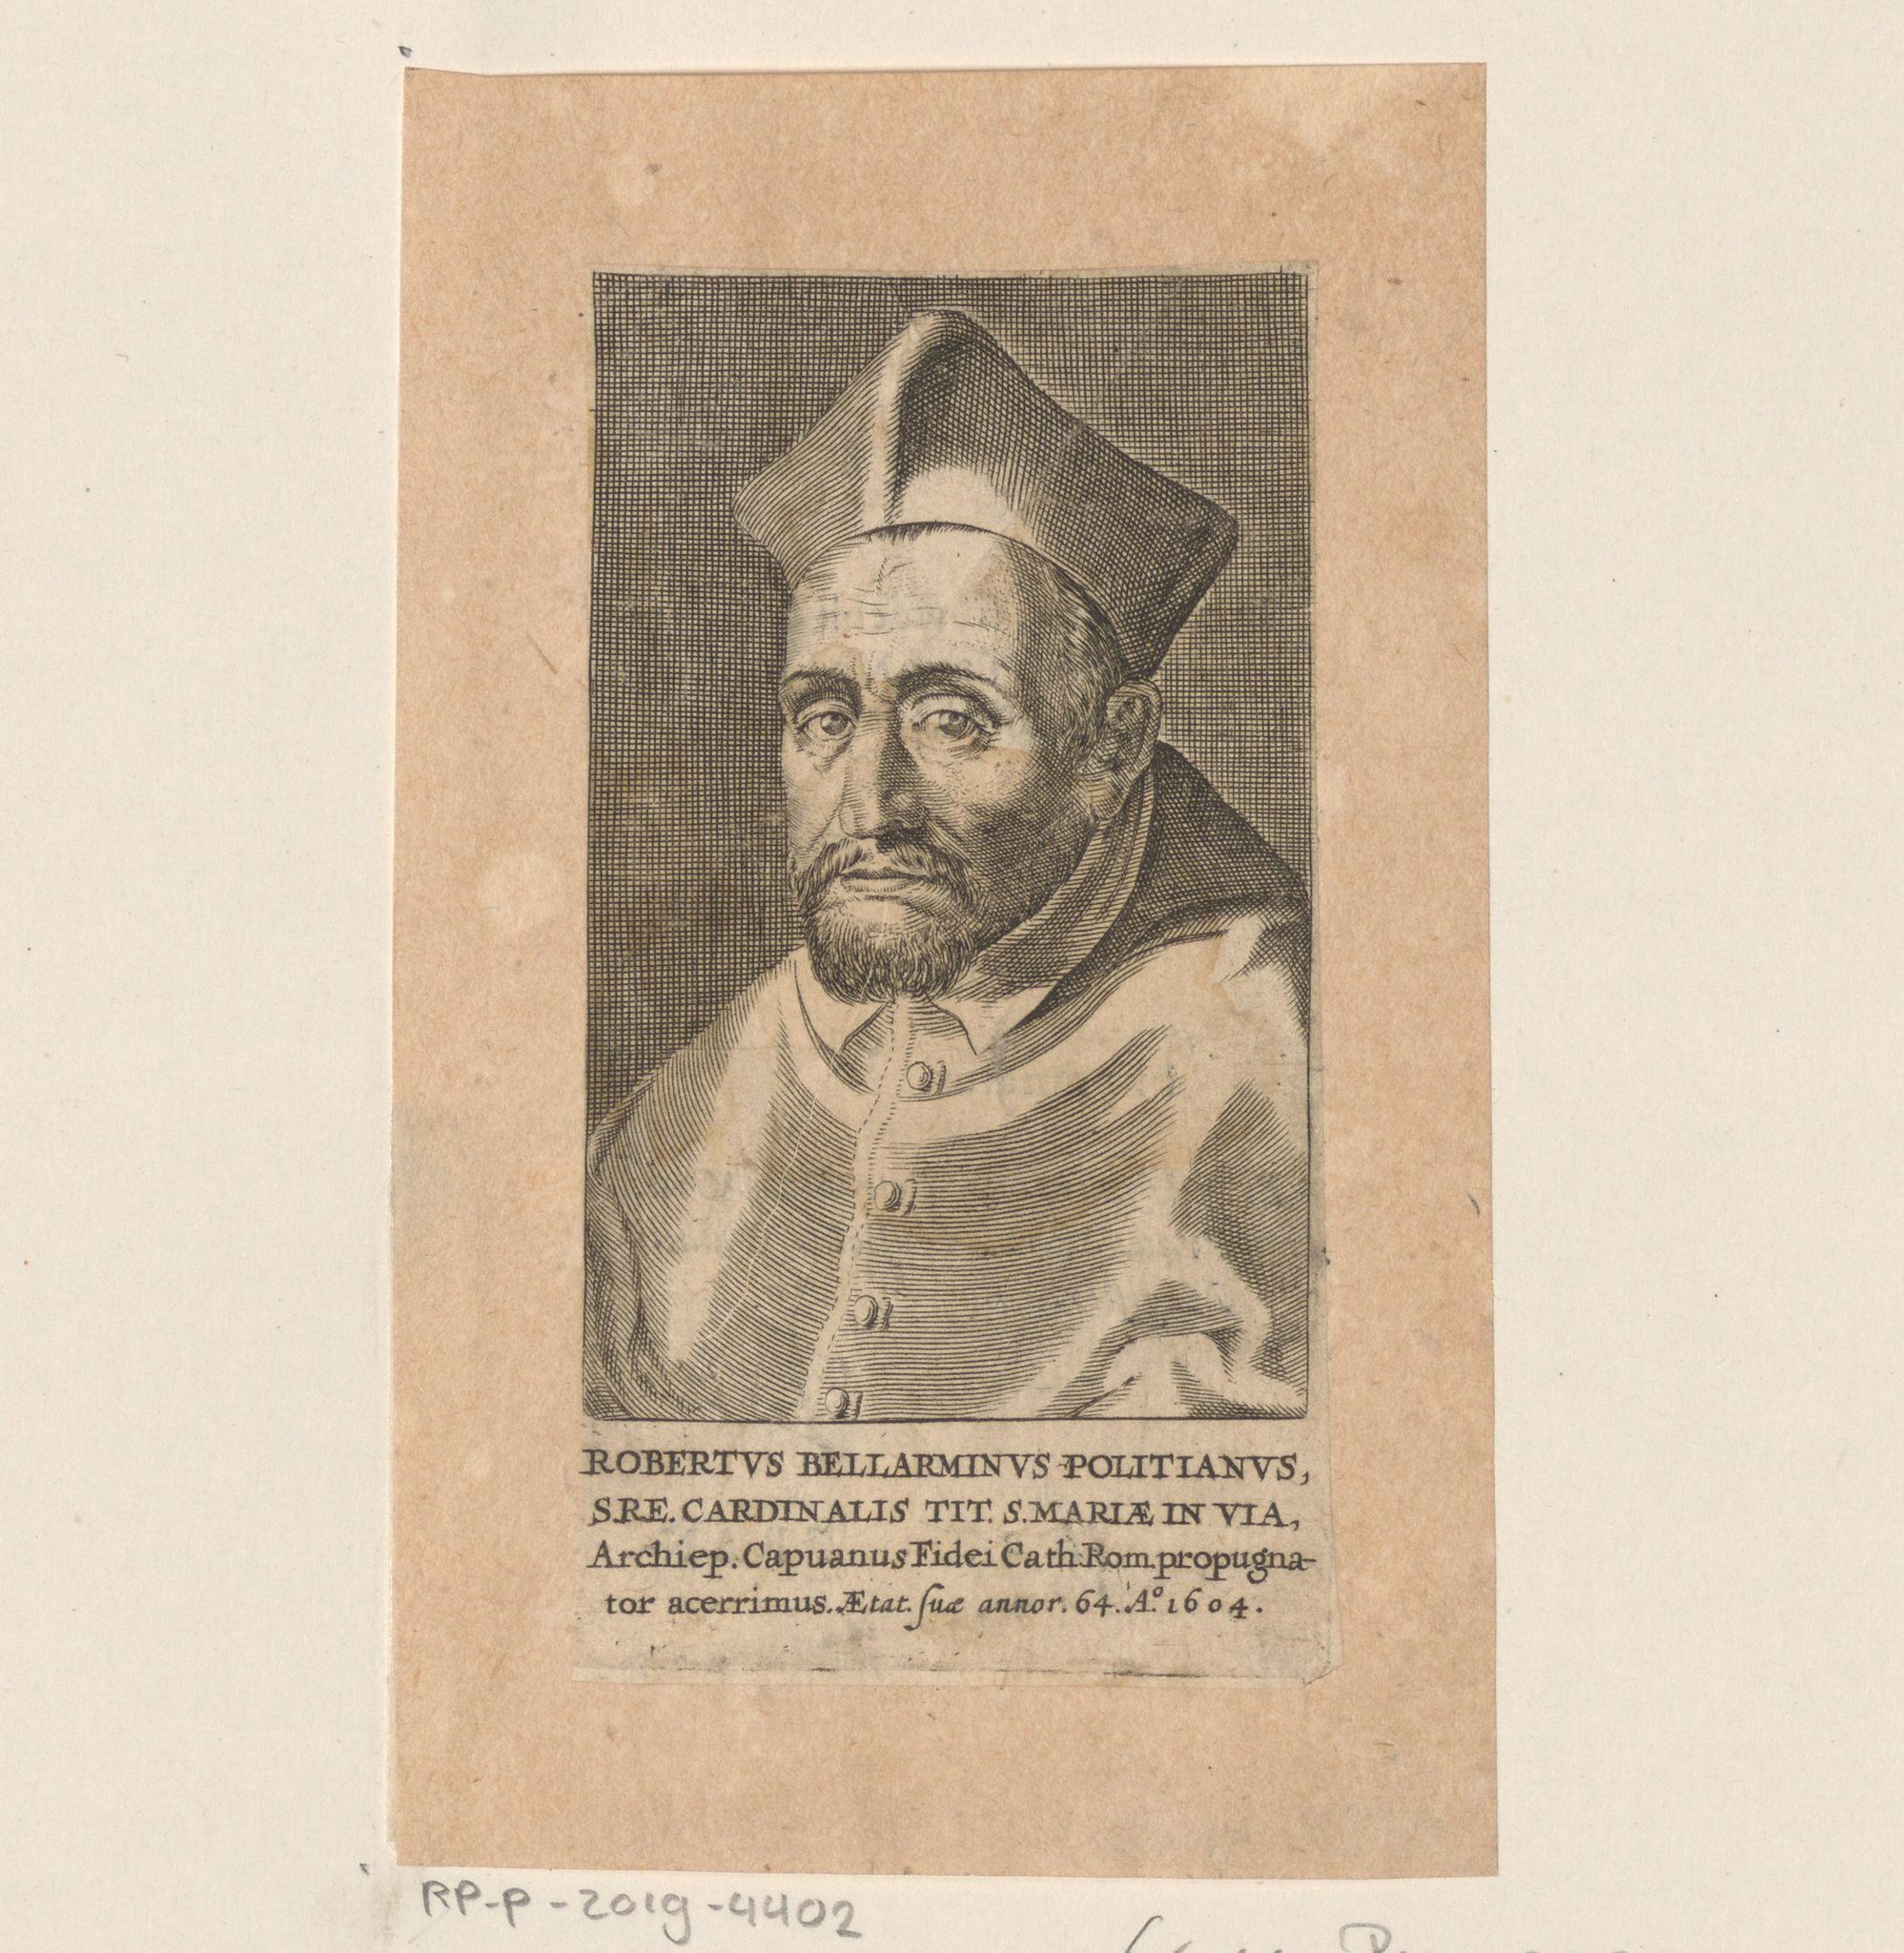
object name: print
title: Portret van kardinaal Roberto Bellarmino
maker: Anonymous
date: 1604-1649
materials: paper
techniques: engraving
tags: cardinal, historical persons